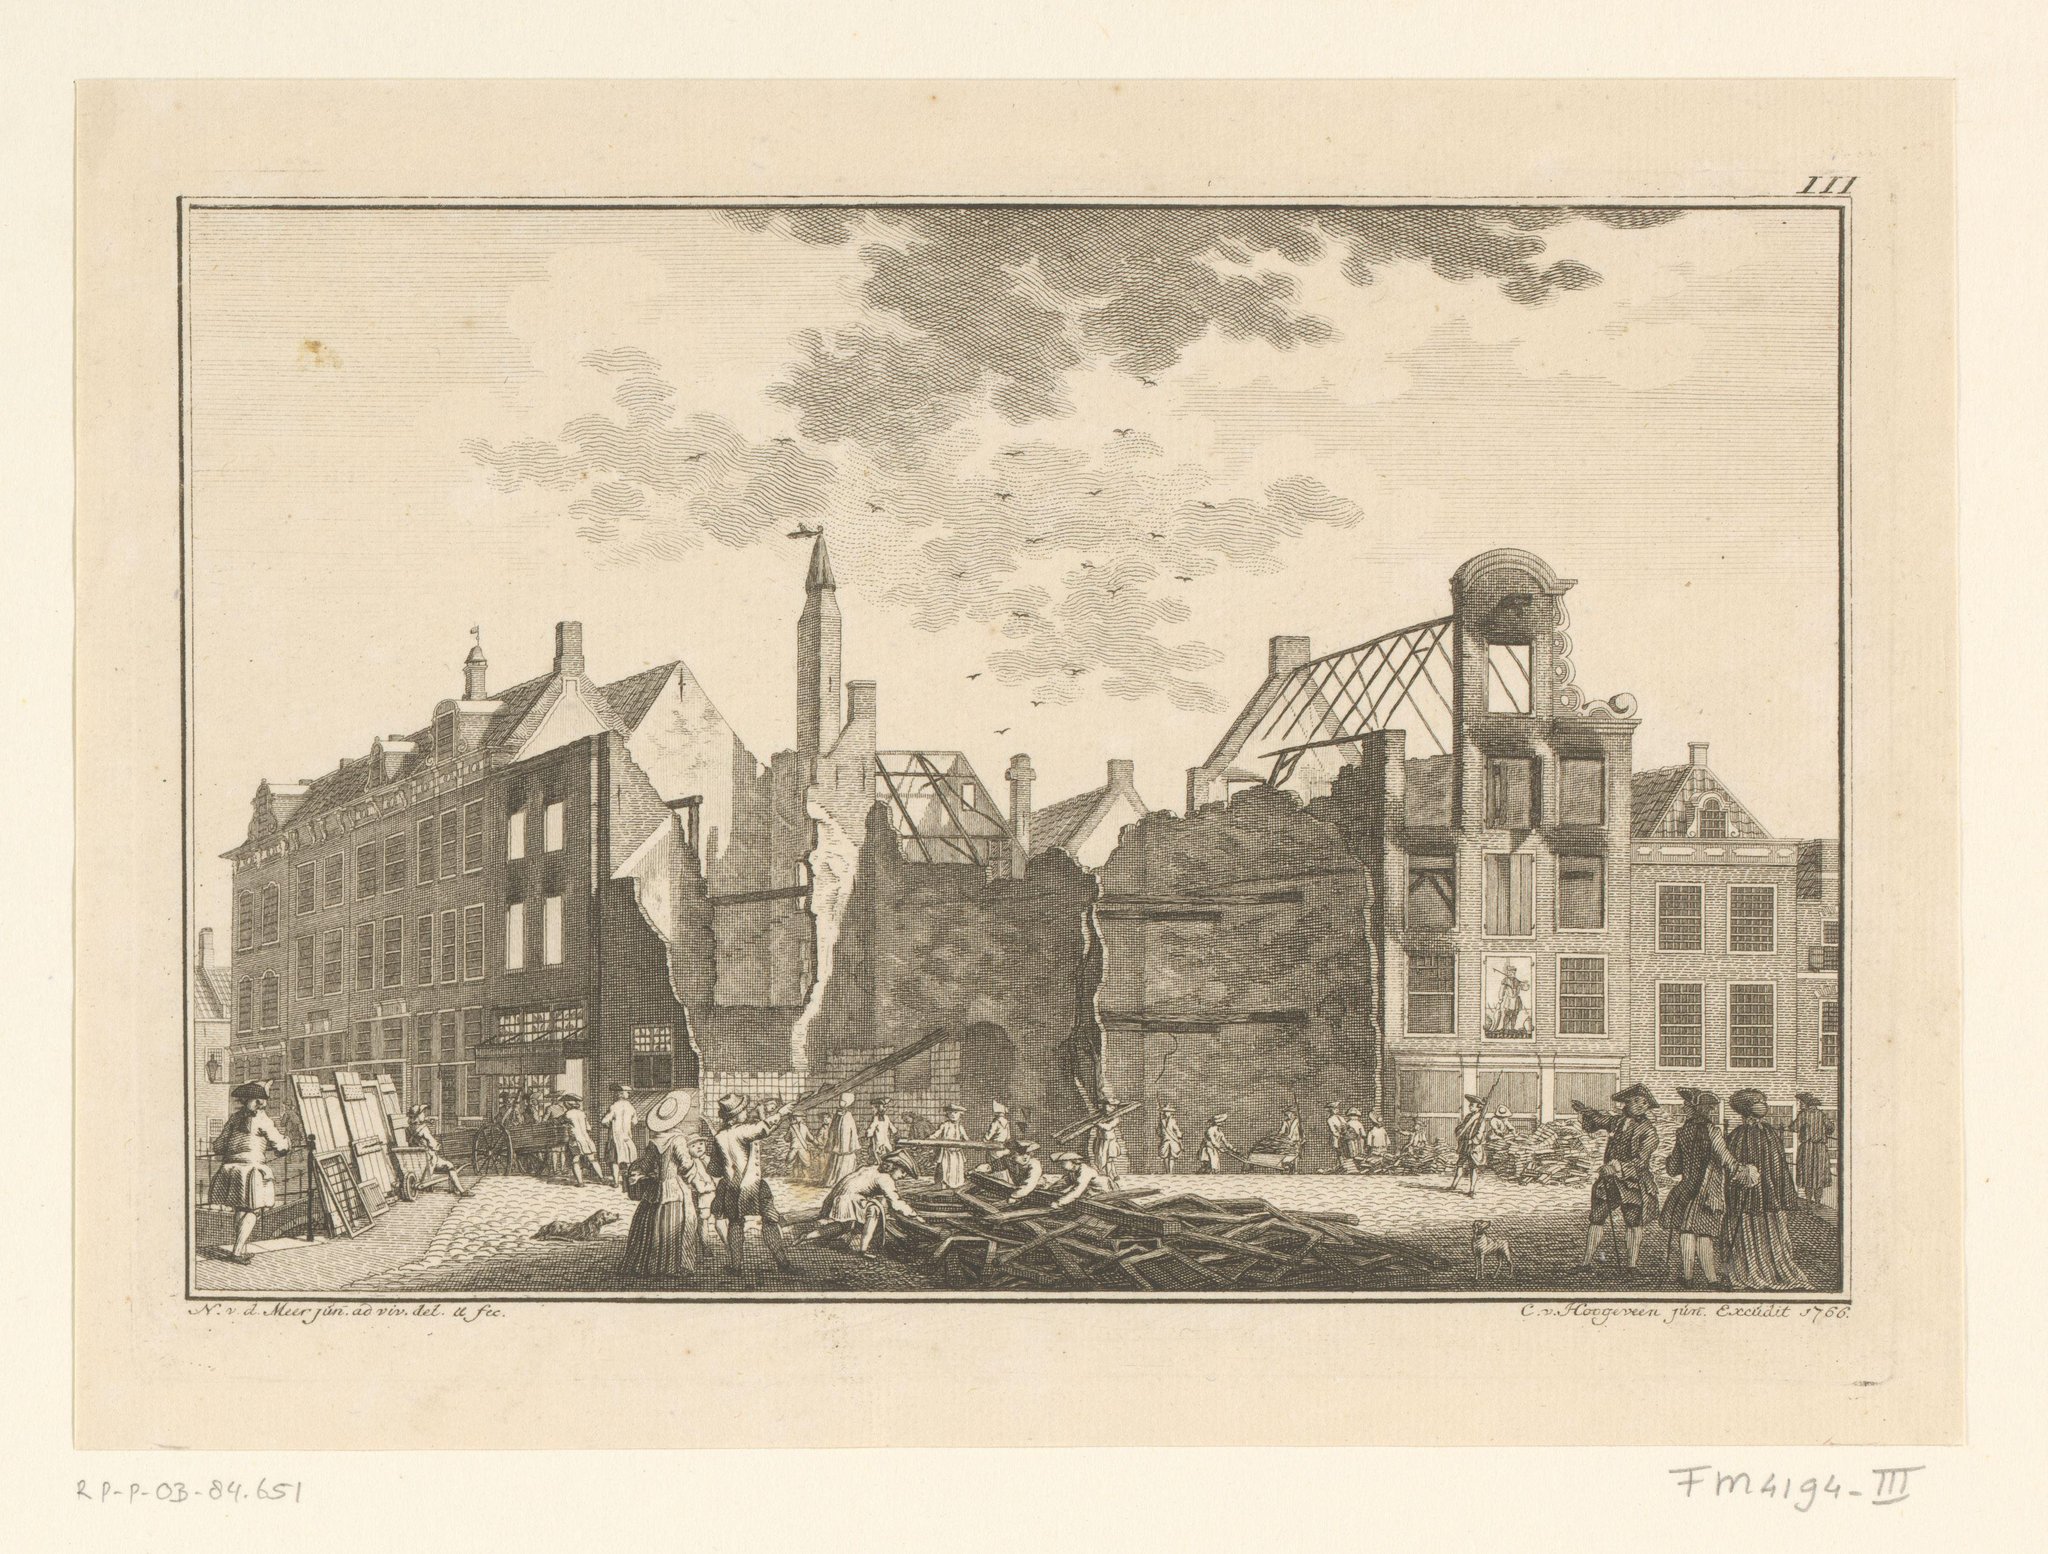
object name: print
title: Na de brand aan de Visbrug te Leiden, 1766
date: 1766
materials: paper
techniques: engraving, etching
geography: leiden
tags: ruin of a dwelling, house, castle, etc., leiden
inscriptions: collector's mark: Lugt 2228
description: Gezicht op de ruïnes van de gebouwen aan de Visbrug en Hoogstraat te Leiden na de brand van 3 oktober 1766. Het puin wordt geruimd en afgevoerd. Rechtsboven genummerd: III. Onderdeel van een serie van vijf platen over de brand van 1766 te Leiden.